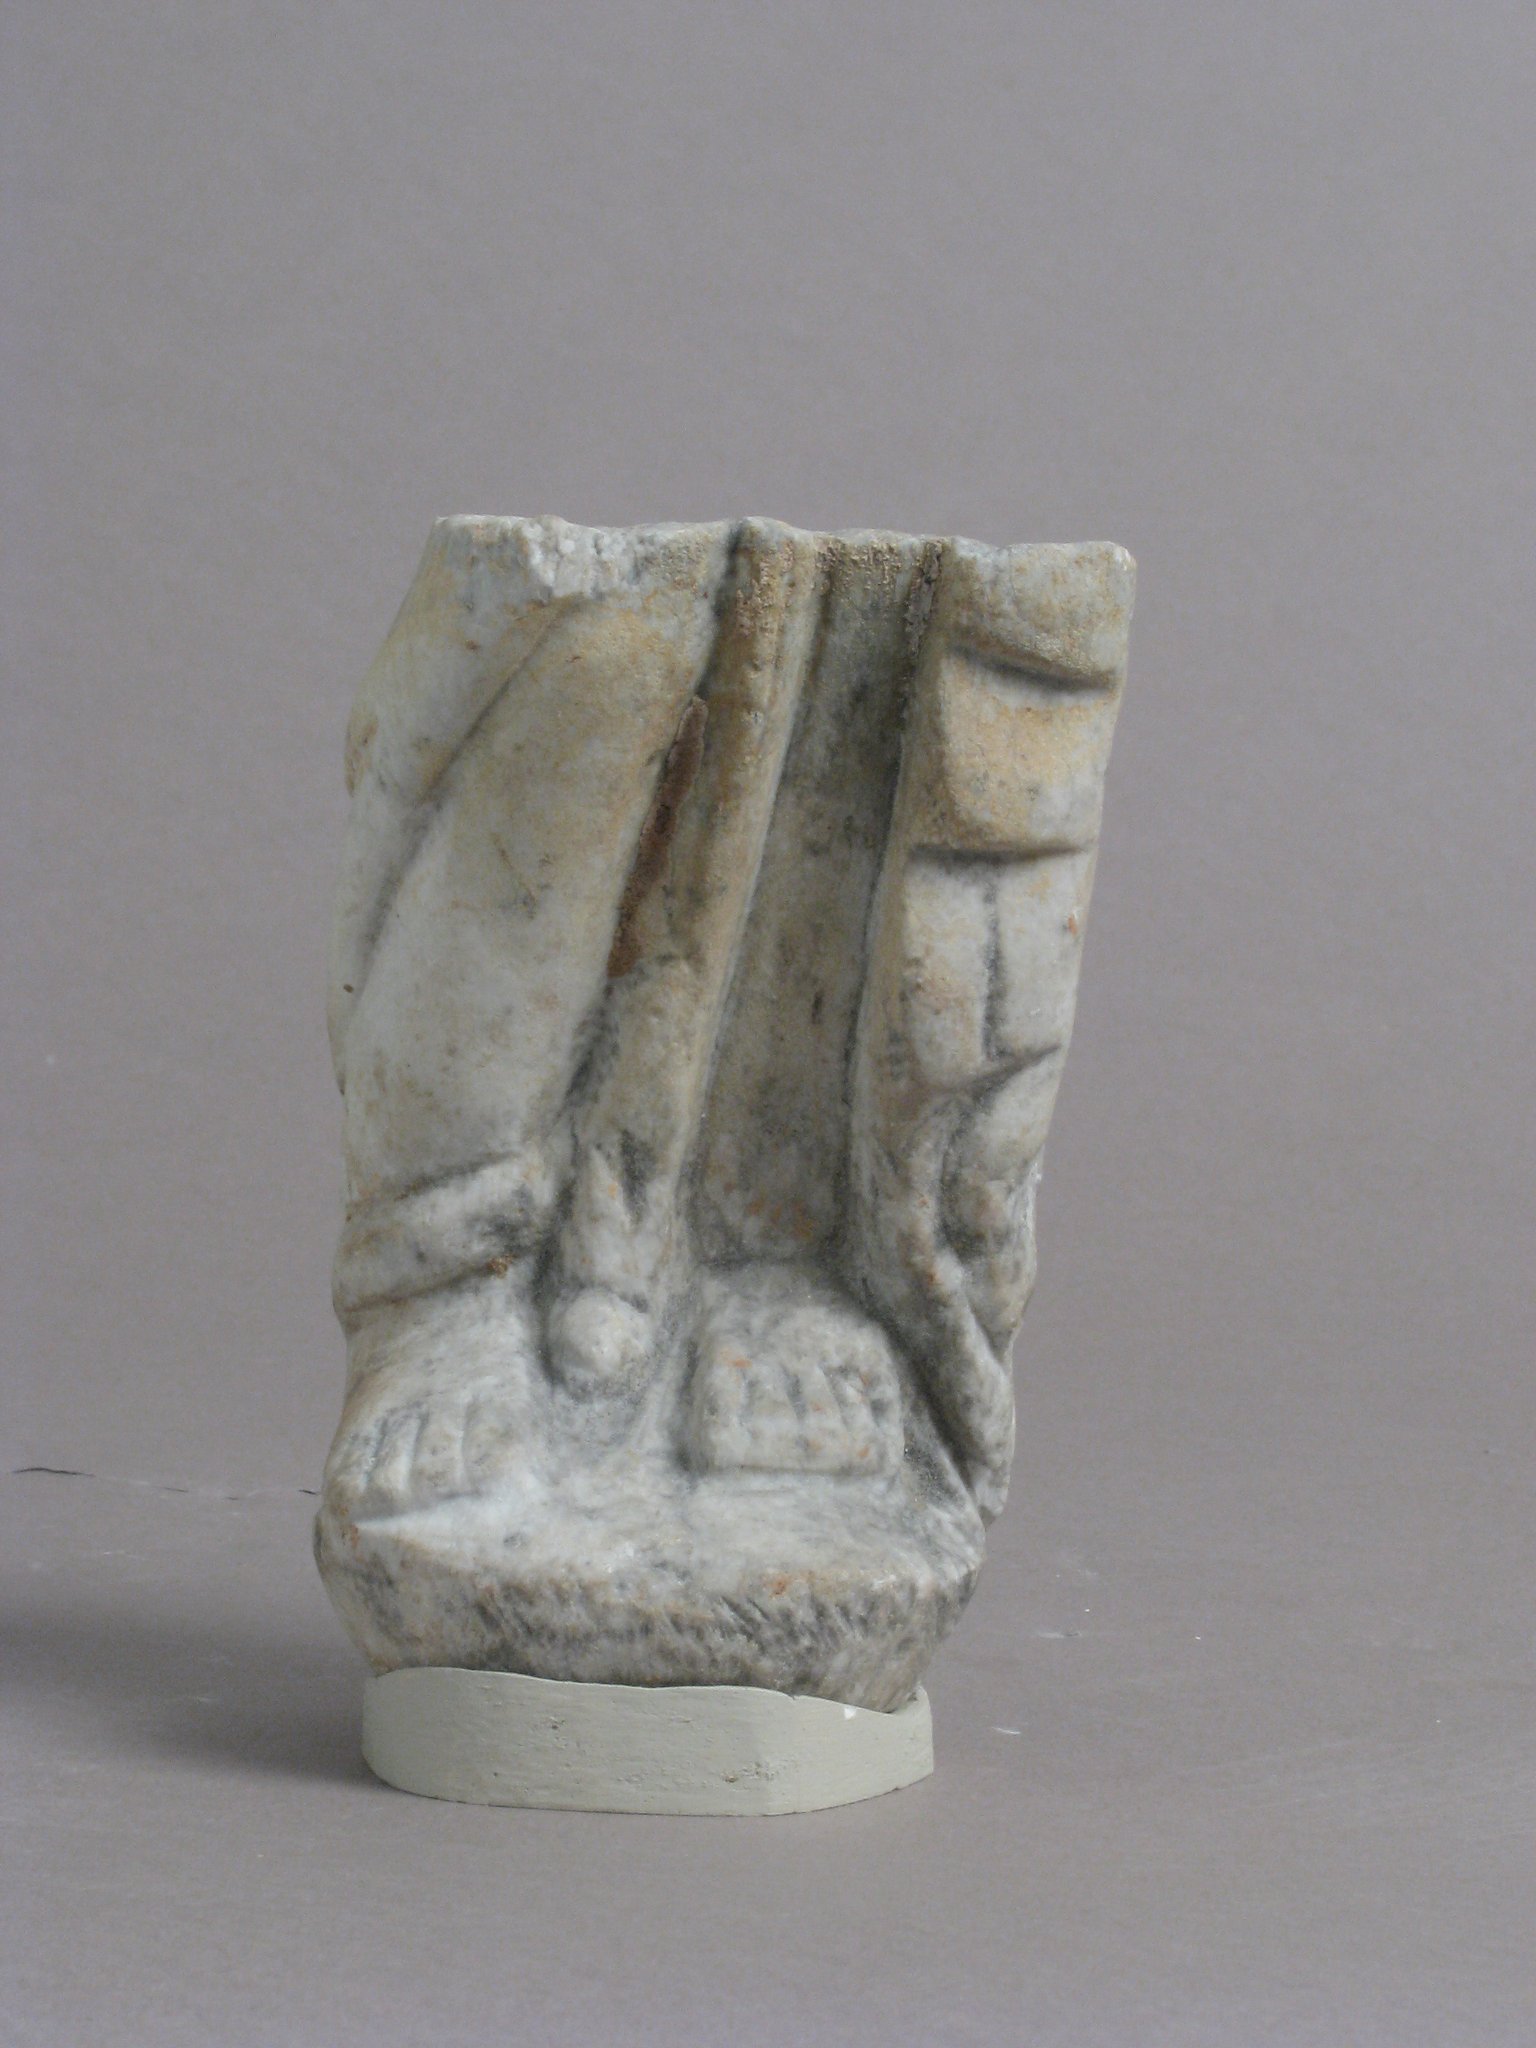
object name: statuette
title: Lower Legs Fragment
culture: coptic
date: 301-700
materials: marble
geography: egypt